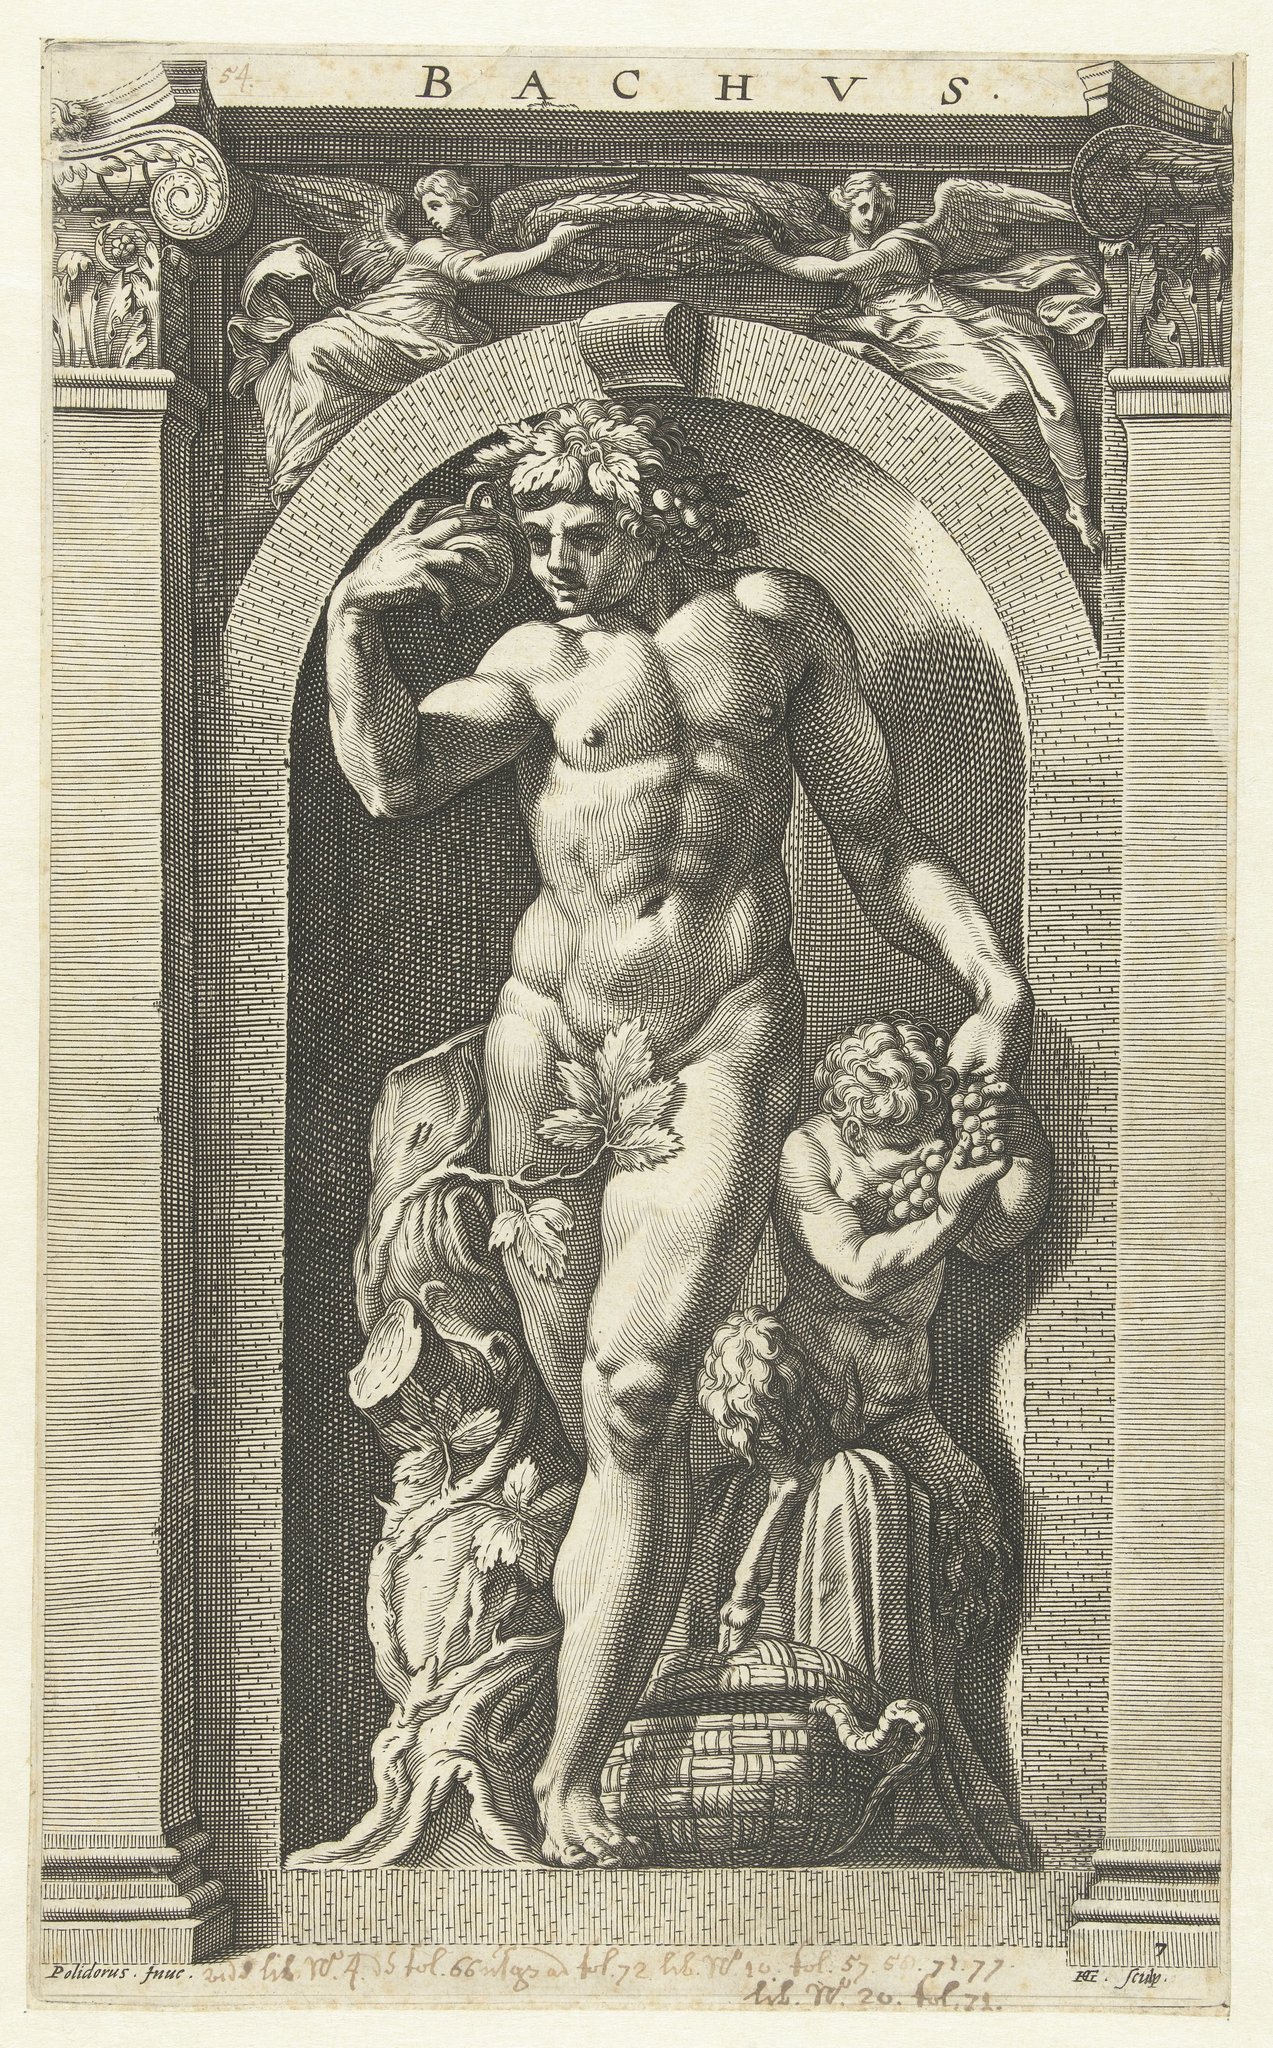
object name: print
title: Bachus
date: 1592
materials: paper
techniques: engraving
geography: haarlem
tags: (story of) bacchus (dionysus), liber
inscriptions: collector's mark: Lugt 10, collector's mark: ‘Hinloopen’, inscription, collector's mark: Lugt 11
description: Bacchus, staand in een nis, een drinkbeker in zijn rechterhand, zijn linkerhand bij de schouder van een kleine sater, die druiven eet. Deze prent is onderdeel van een serie van acht prenten van klassieke goden, gebaseerd op schilderingen van Polidoro da Caravaggio op de façade van een Romeins huis, door Goltzius in Rome gezien en nagetekend.